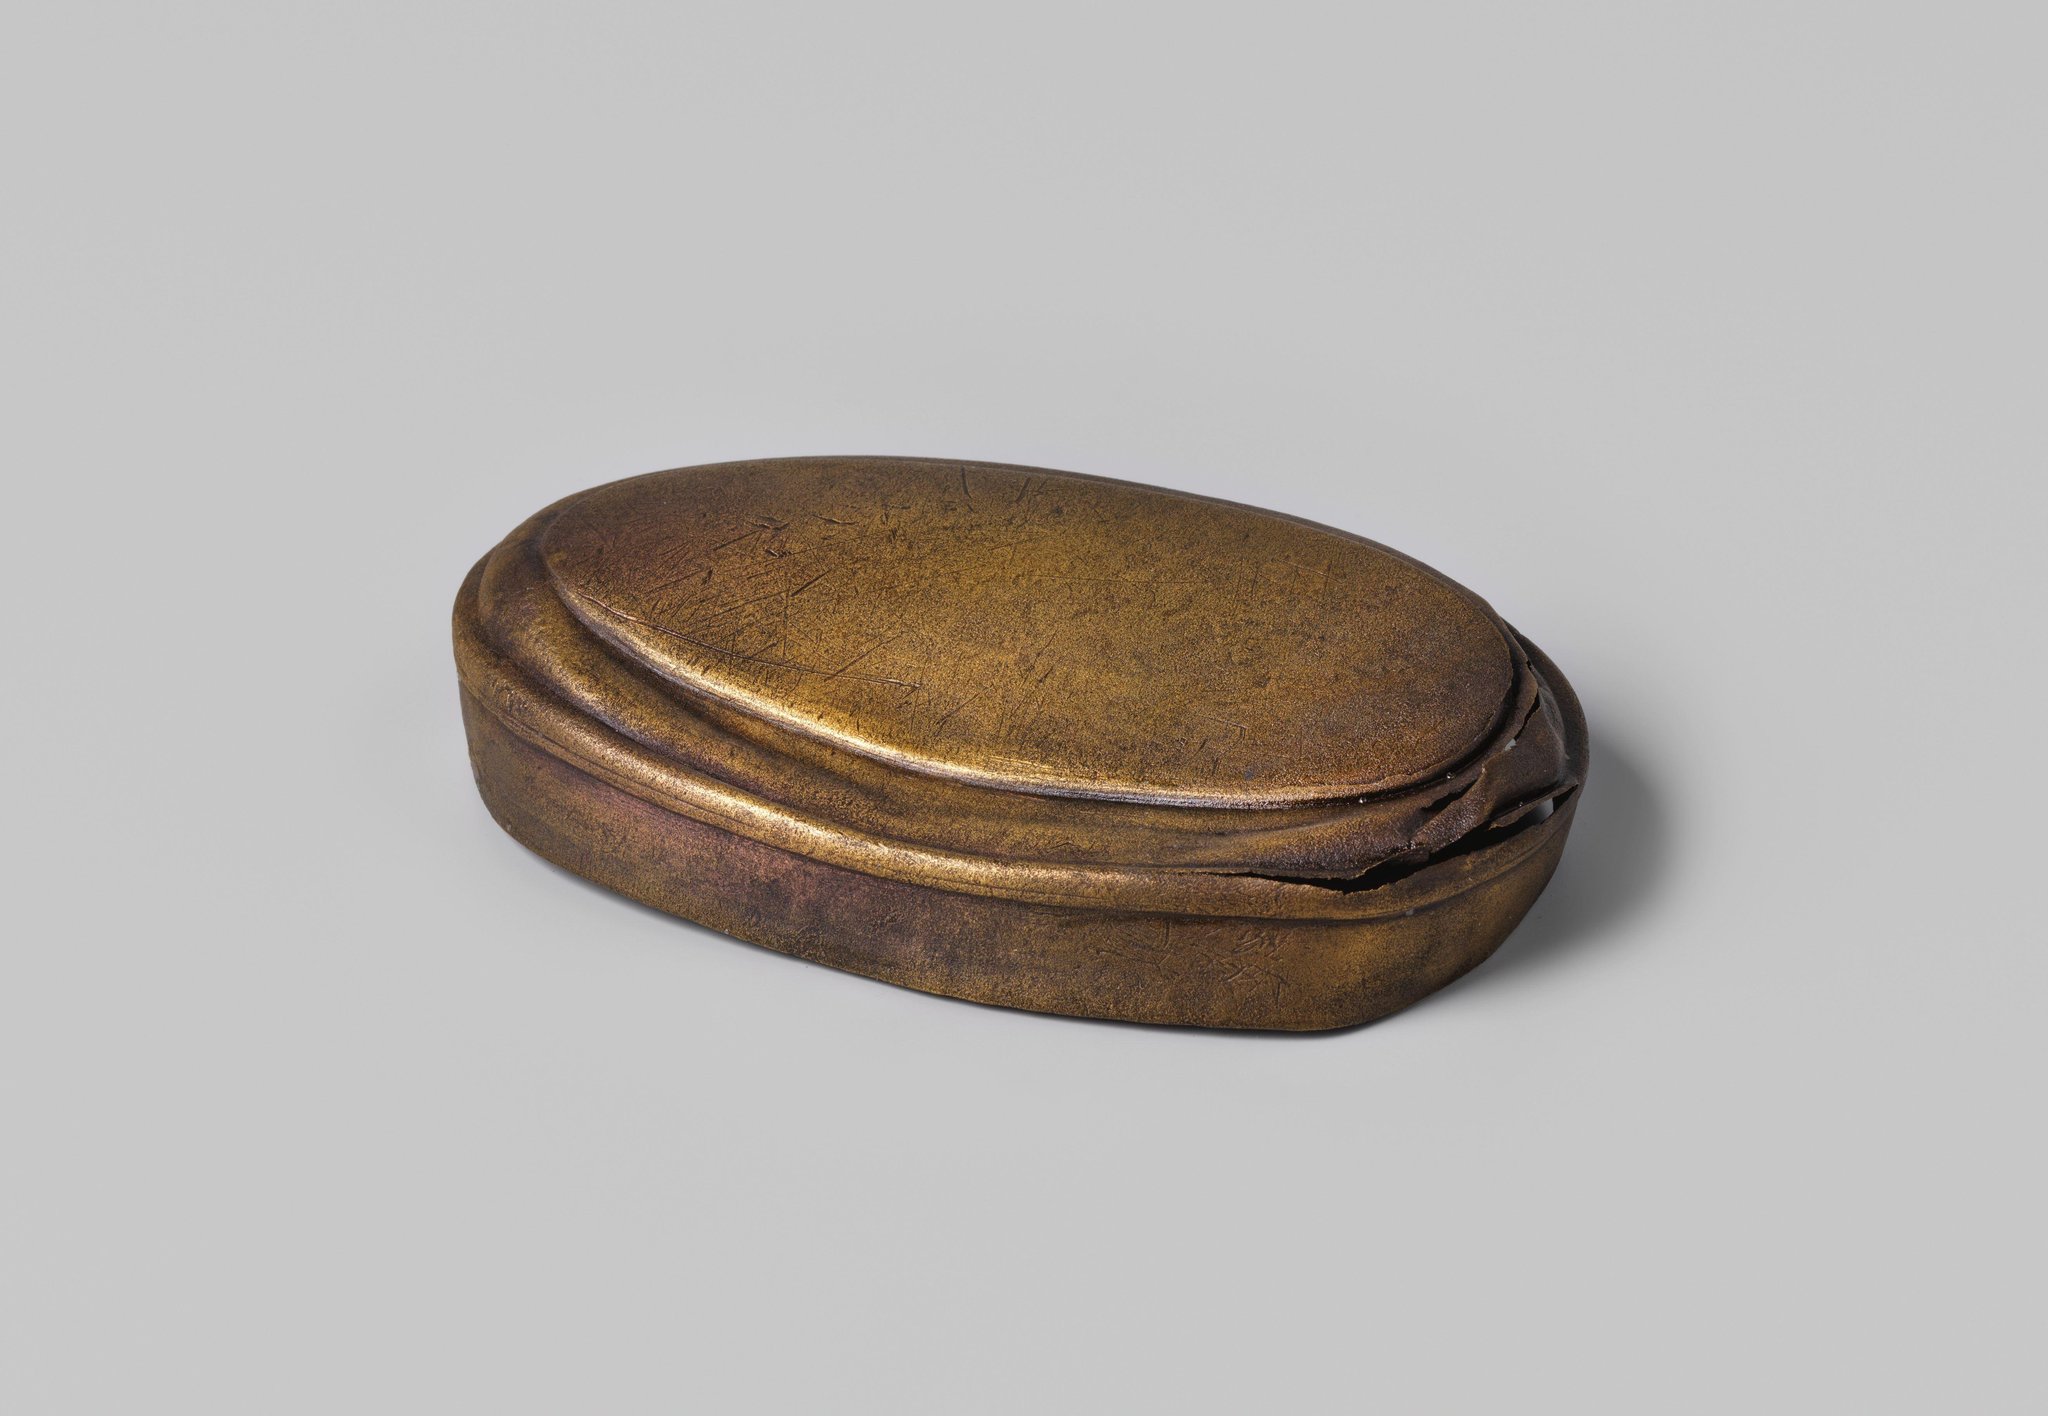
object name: tobacco box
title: Tabaksdoos zonder deksel uit het wrak van de Oost-Indiëvaarder Hollandia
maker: Anonymous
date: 1700-1743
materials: copper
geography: netherlands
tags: verenigde oostindische compagnie, hollandia (schip), annet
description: Tobacco box; fragm, box, id. NG 1980-27H2021 (c.12.2x7), hinge missing (3 rivet eyes).